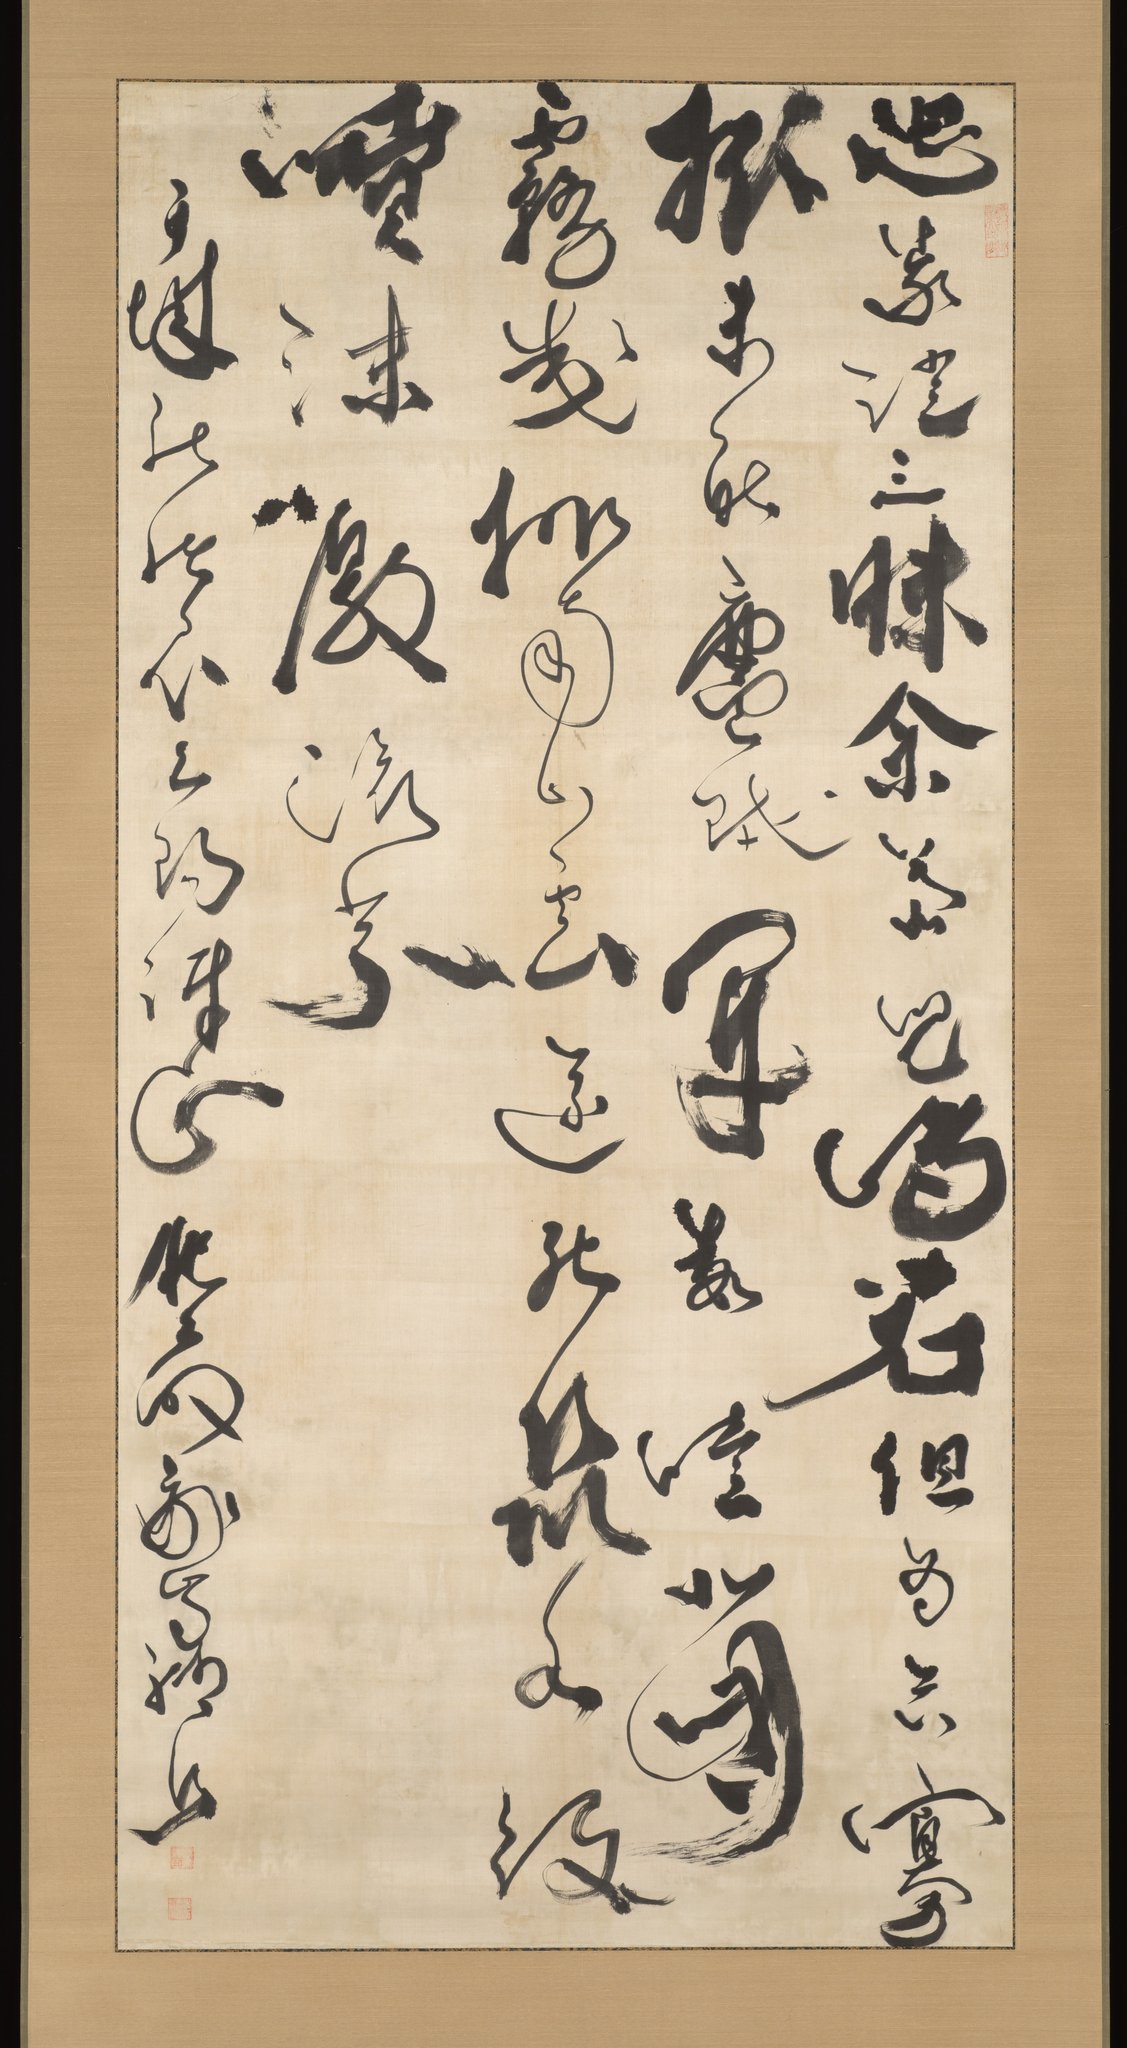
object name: hanging scroll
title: Calligraphy in Cursive Script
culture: japanese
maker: soejima taneomi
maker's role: artist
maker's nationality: japanese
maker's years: 1828-1905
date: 1867-1900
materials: ink, textile